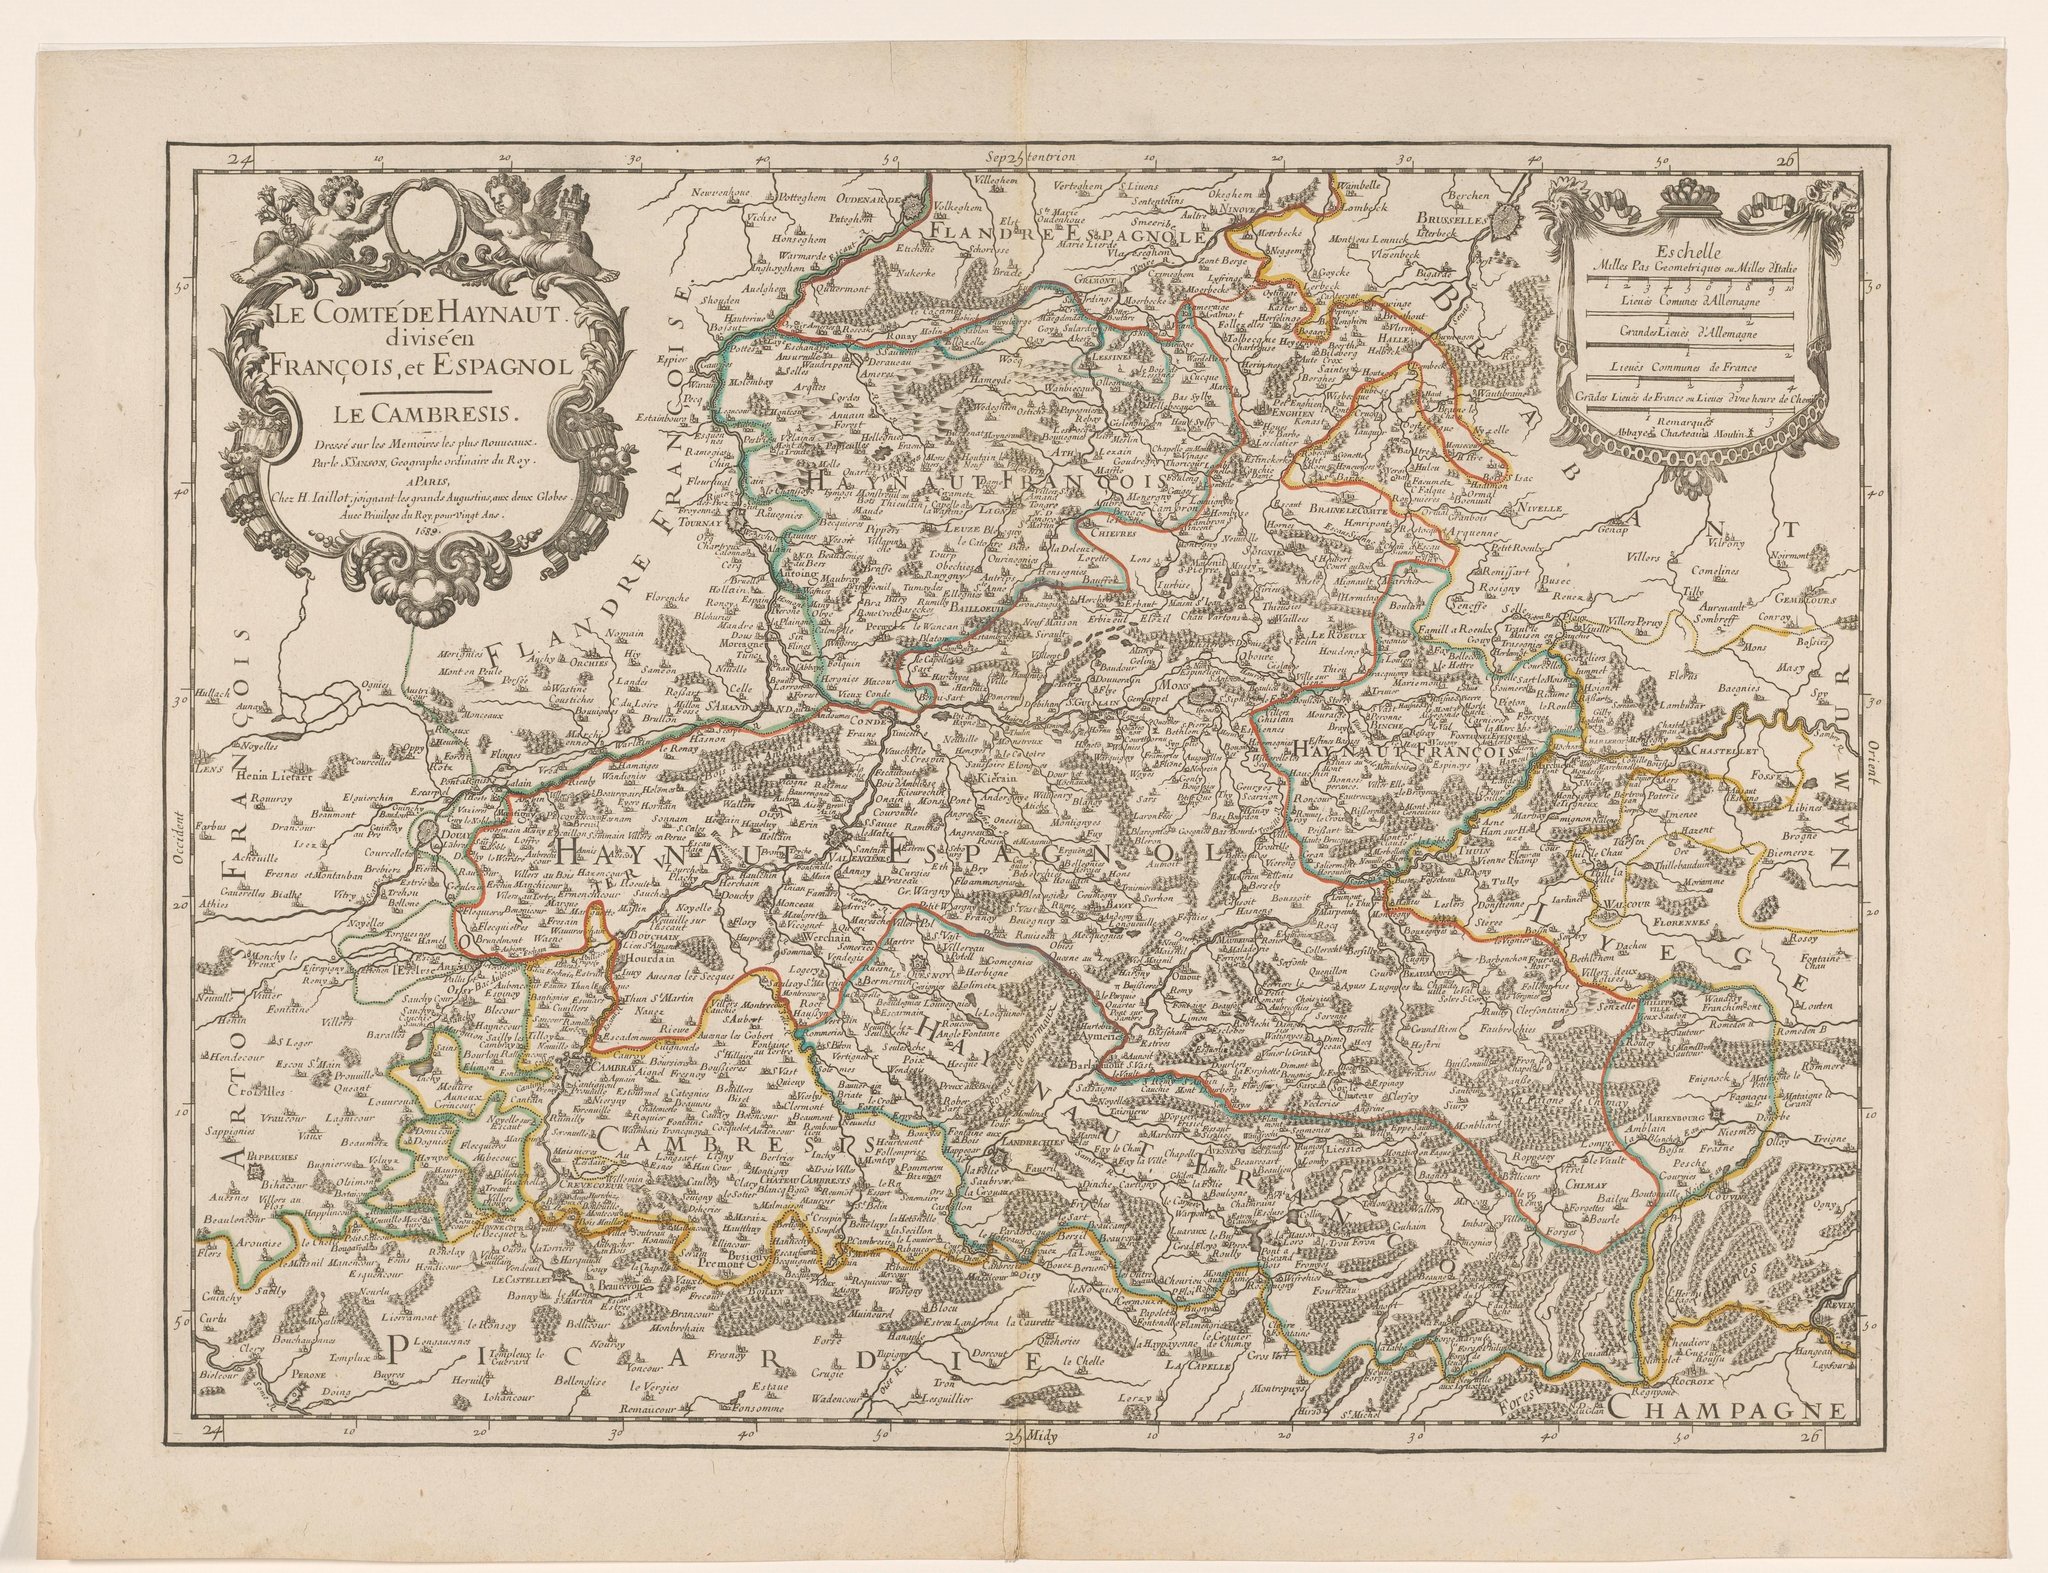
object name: map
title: Kaart van het graafschap Henegouwen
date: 1689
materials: paper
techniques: engraving, etching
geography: paris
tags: maps of separate countries or regions, henegouwen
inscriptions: collector's mark: Lugt 195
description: Kaart van het graafschap Henegouwen. Linksboven de titelcartouche. Rechtsboven een cartouche met vijf schaalstokken: 10 Milles Pas Geometriques ou Milles d'Italie / 2 Lieues Communes dAllemagne / 2 Grandes Lieues d'Allemagne en twee andere. Hieronder een legenda. De kaart is voorzien van een gradenverdeling langs de randen.